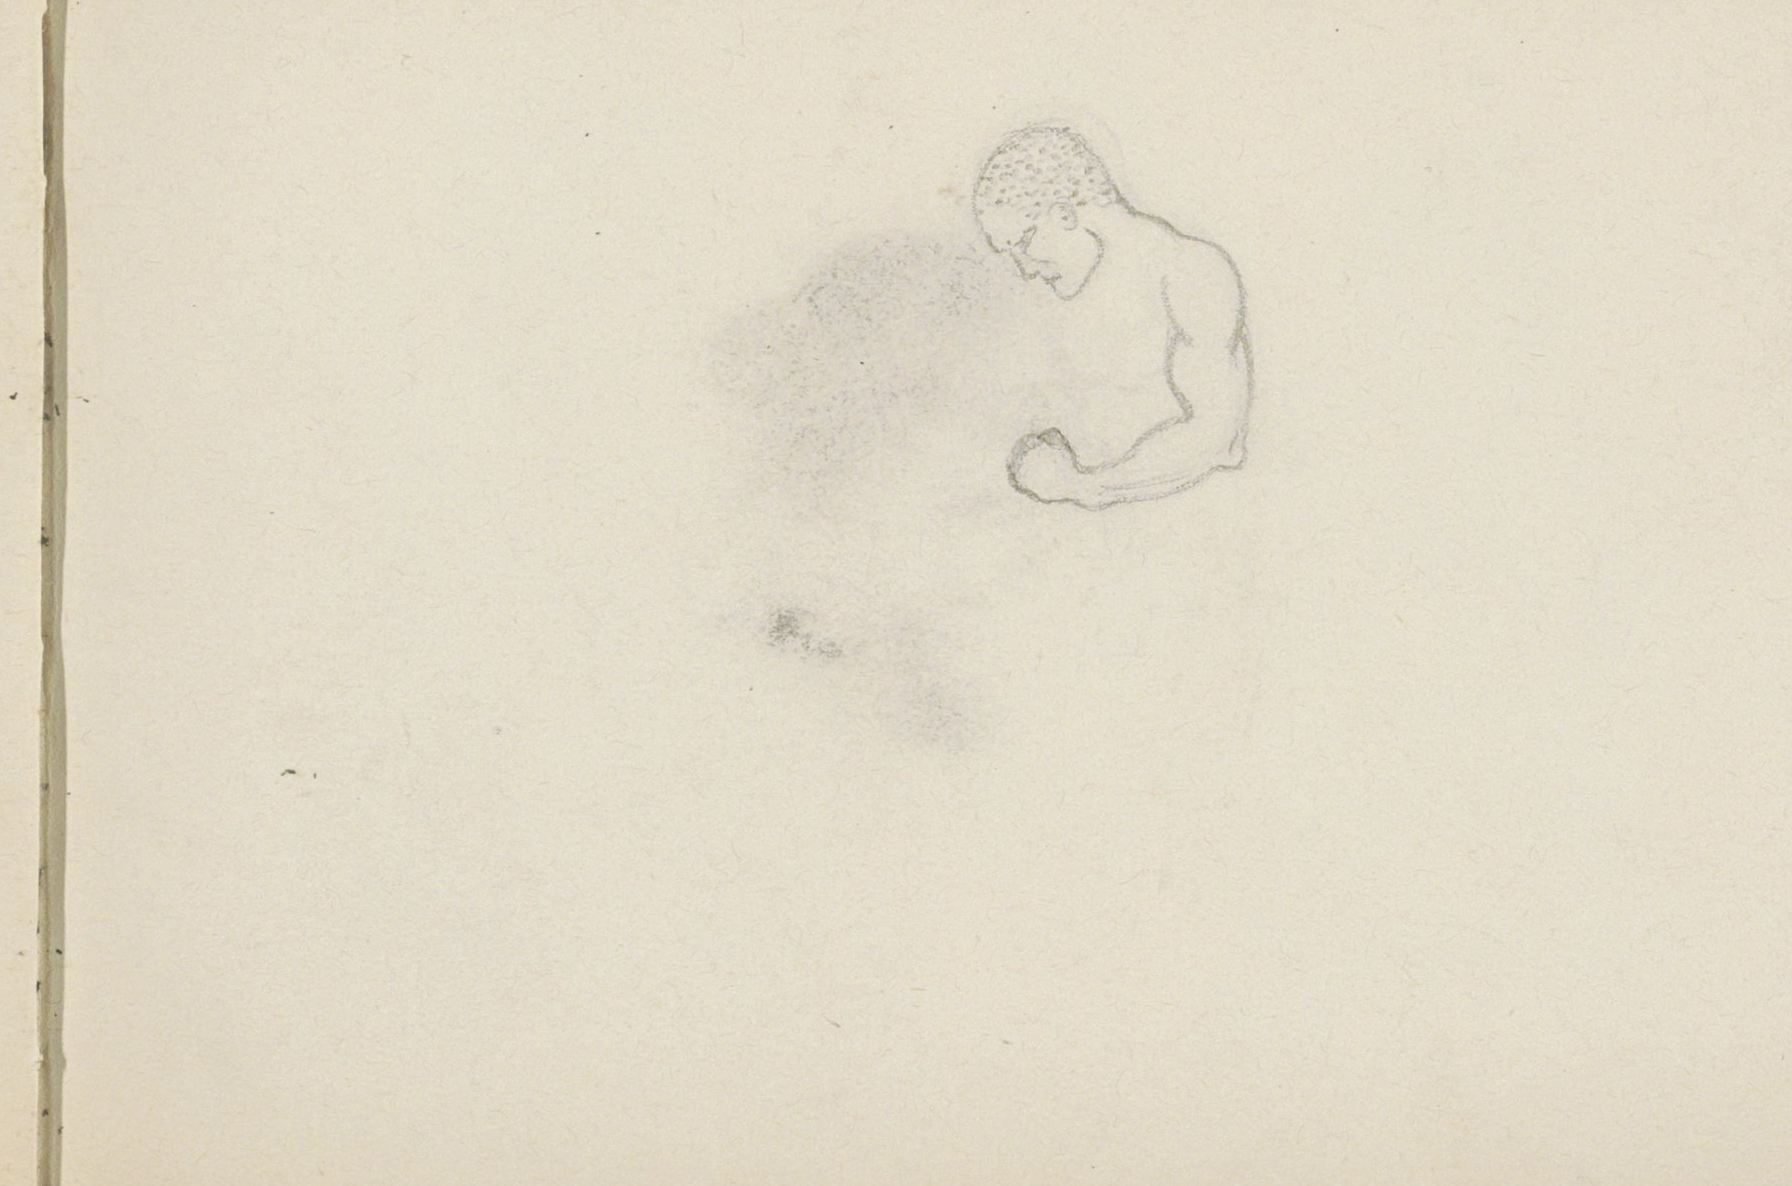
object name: sketchbook leaf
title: Man die de spieren in zijn ontblote linkerarm aanspant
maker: julie de graag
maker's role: draughtsman, print maker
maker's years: 1877-1924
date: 1894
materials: paper, pencil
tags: adult man, muscles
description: Blad 23 recto uit een schetsboek met 35 bladen.